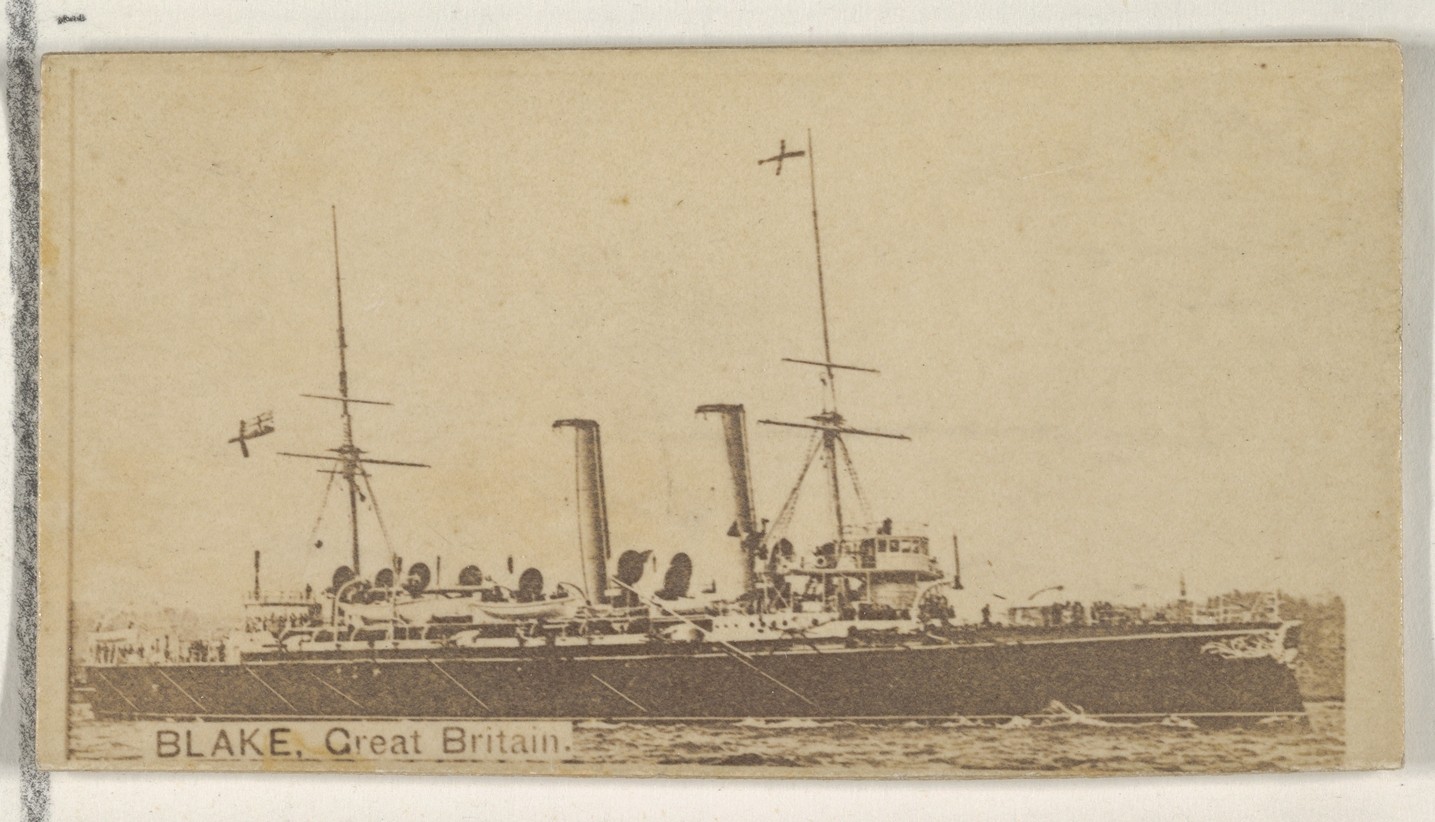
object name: photograph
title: Blake, Great Britain, from the Famous Ships series (N50) for Virginia Brights Cigarettes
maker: allen & ginter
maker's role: publisher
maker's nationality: american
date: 1895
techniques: albumen silver print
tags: ships